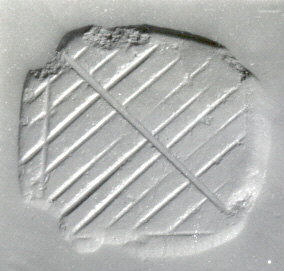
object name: stamp seal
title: Loop-handled rectangular stamping device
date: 7000-5001 BCE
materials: mineral, stone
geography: northern syria (?)